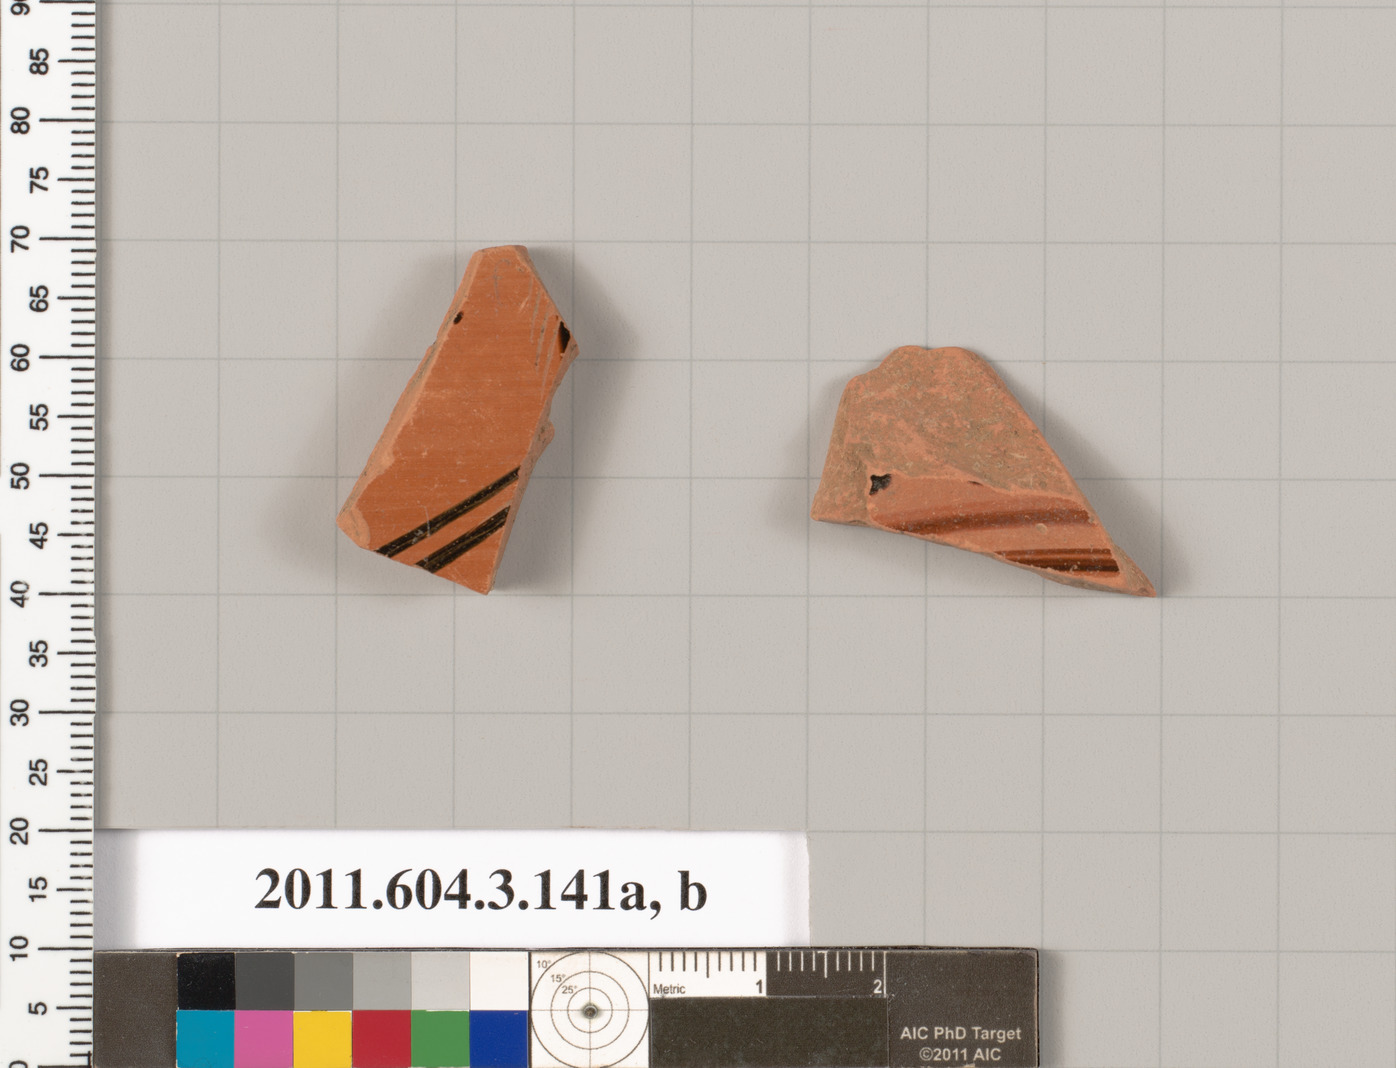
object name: undetermined closed shape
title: Terracotta fragments from closed shapes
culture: greek, attic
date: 600-401 BCE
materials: terracotta